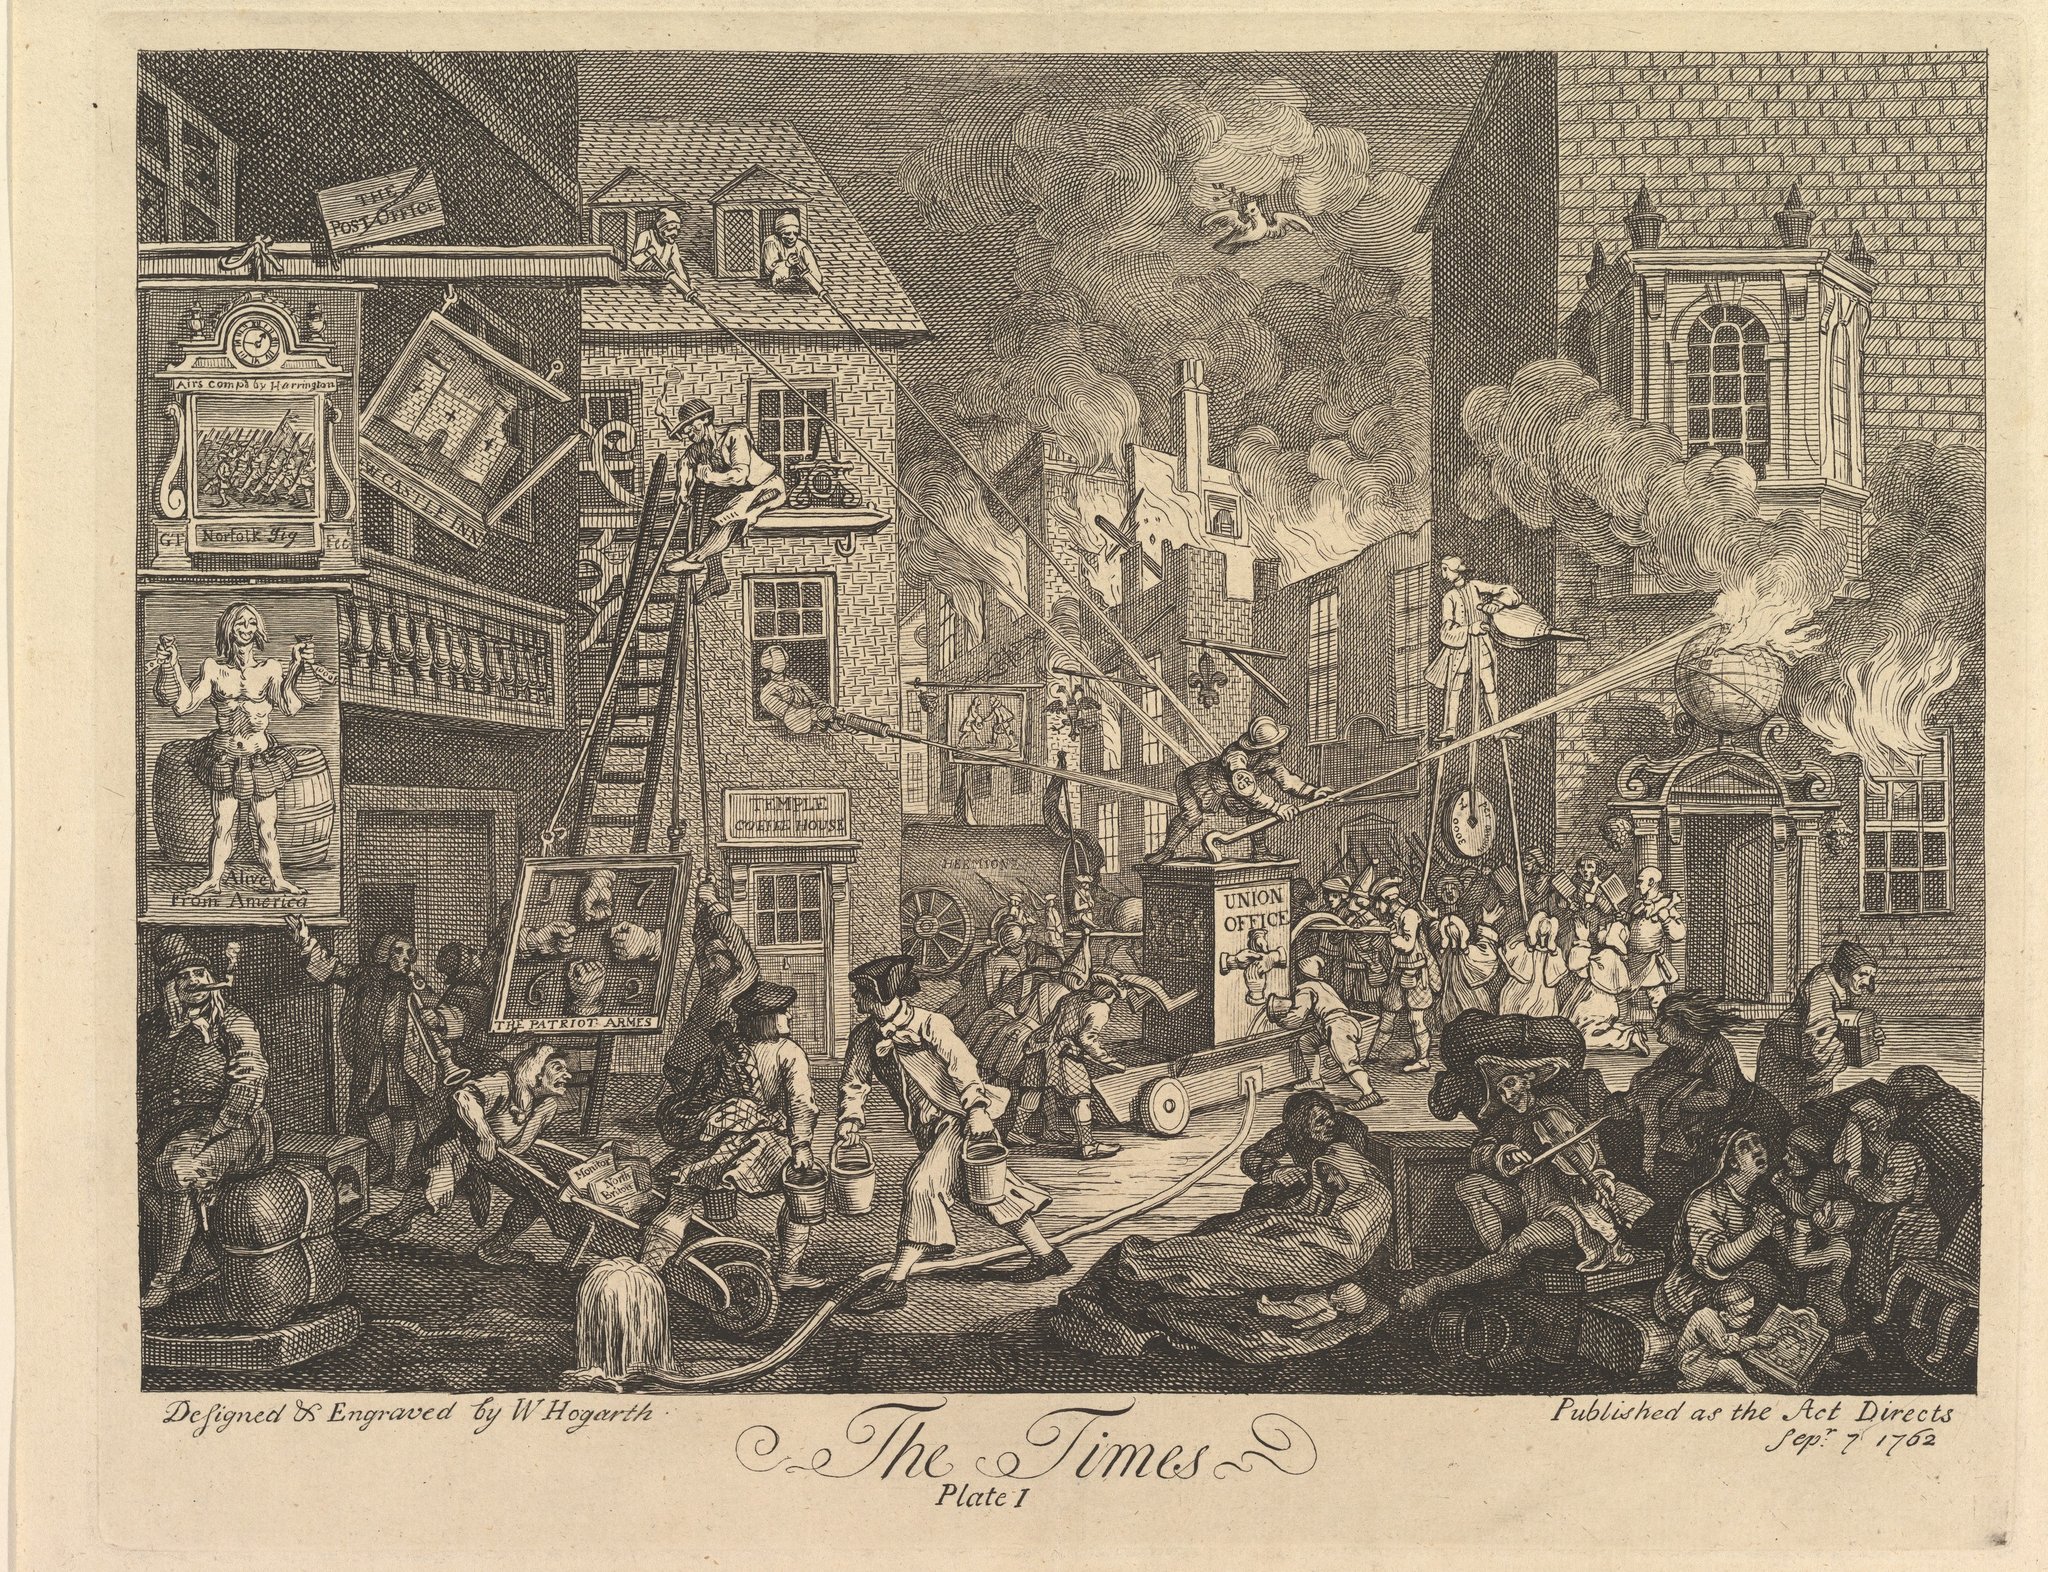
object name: print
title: The Times, Plate 1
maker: william hogarth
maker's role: artist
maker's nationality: british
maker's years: 1697-1764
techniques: engraving, etching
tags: satire,buildings,men,women,fires,firefighters,london